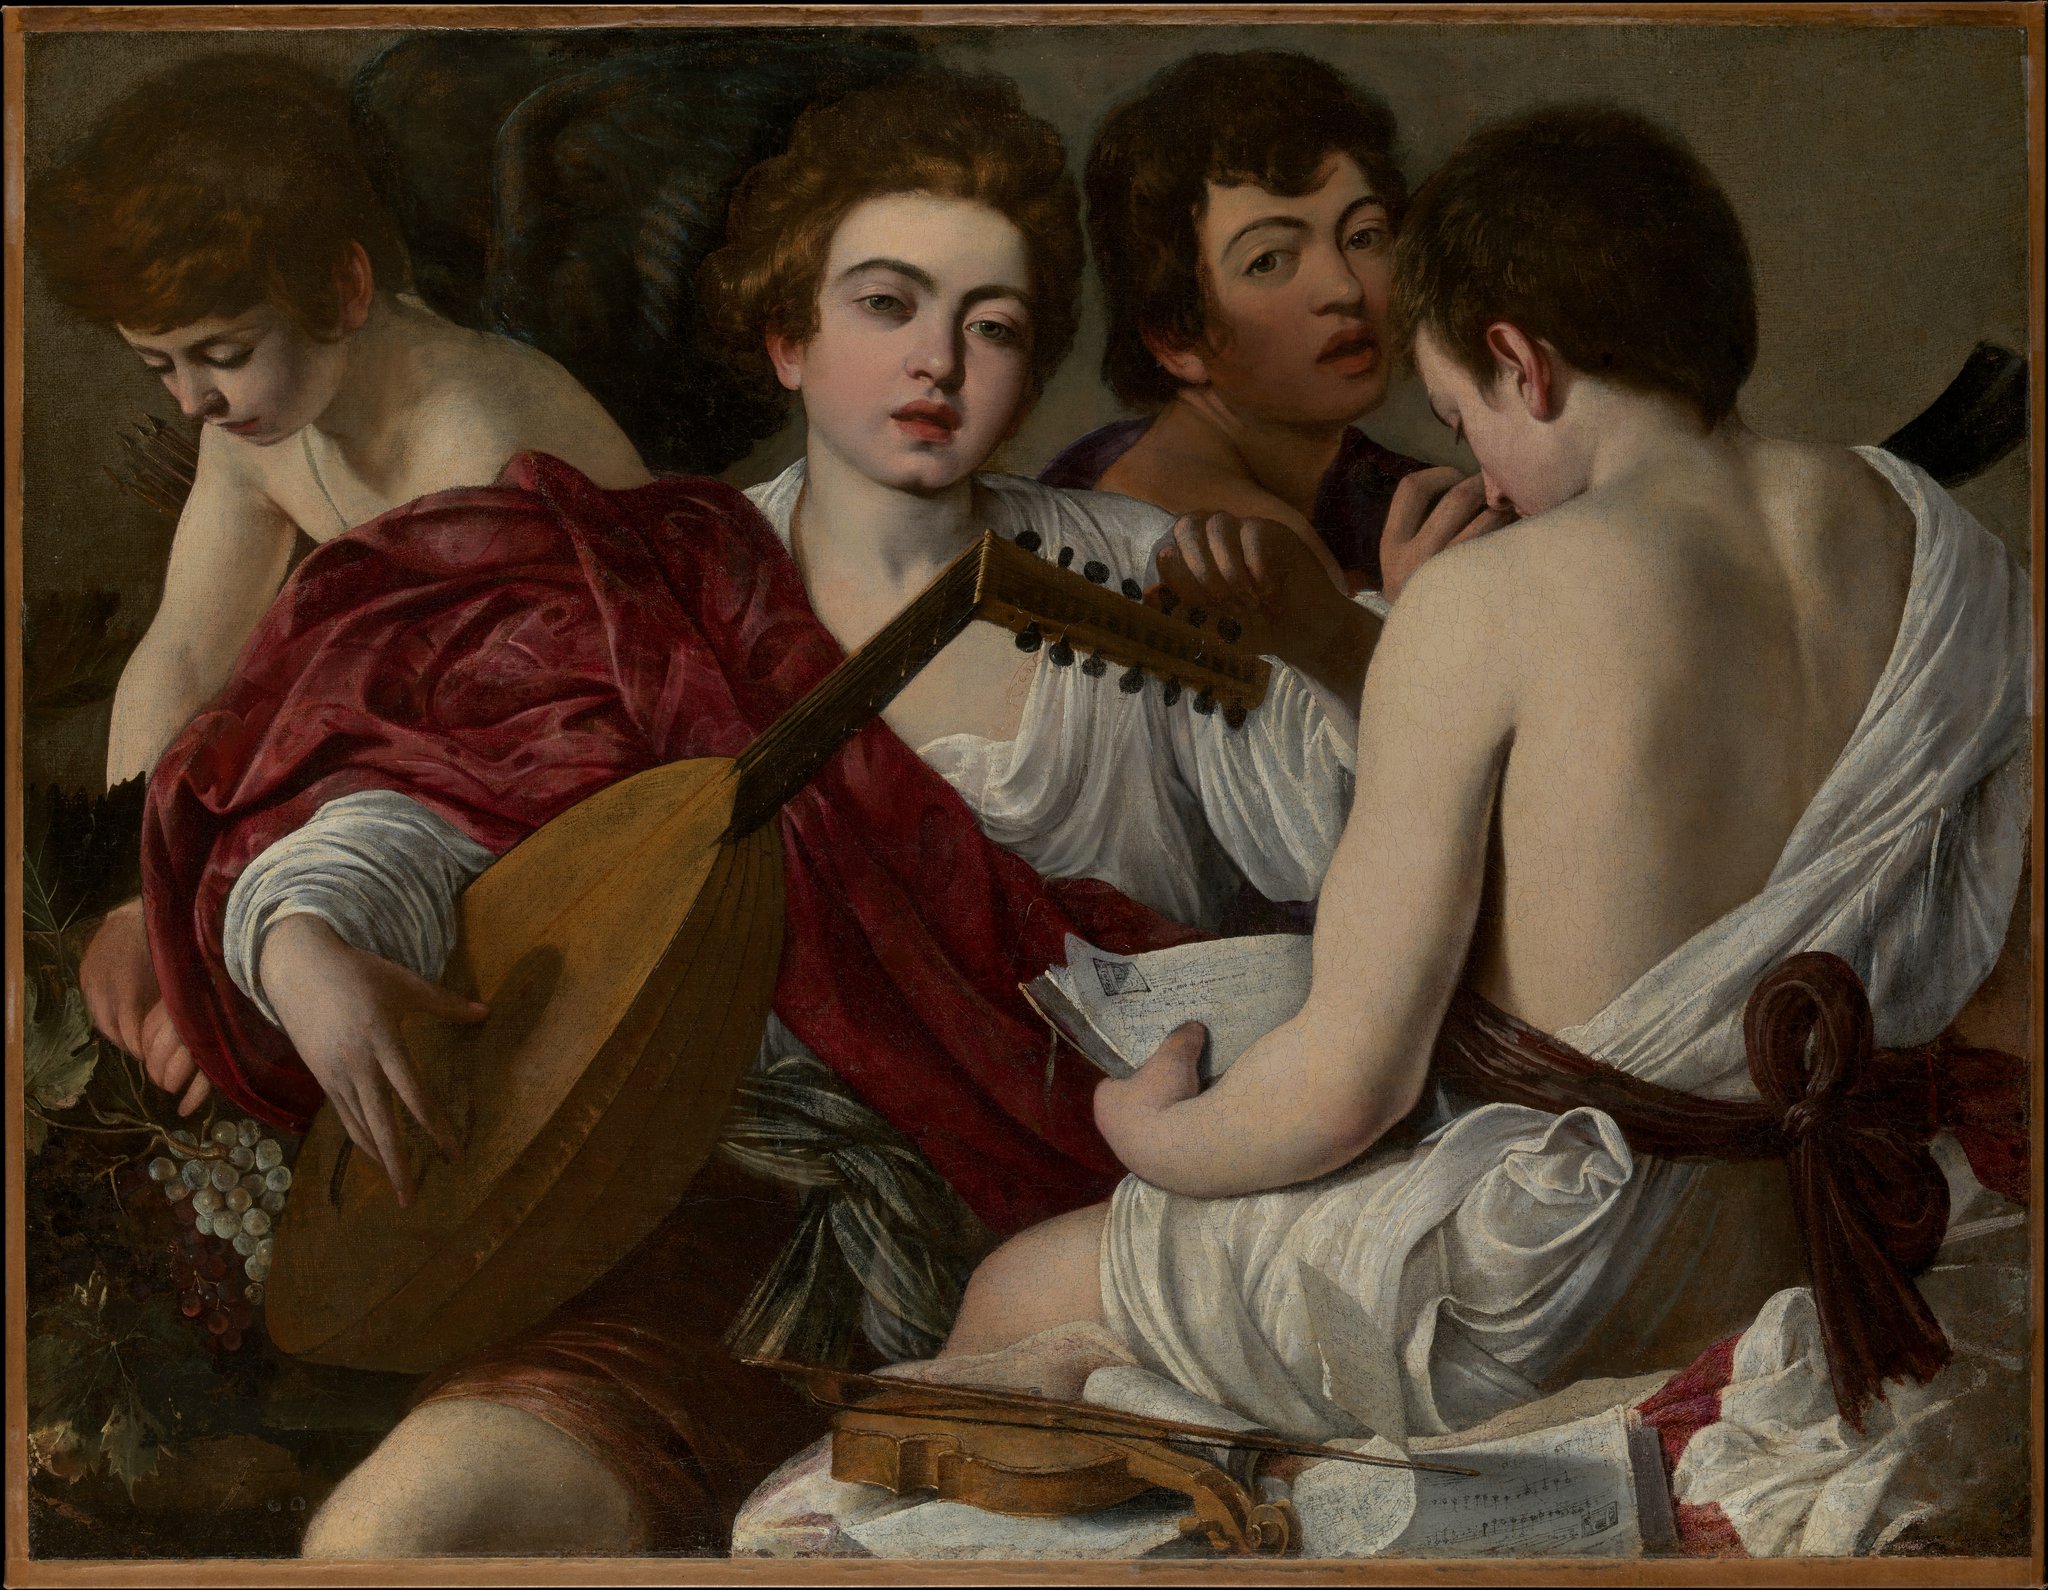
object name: painting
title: The Musicians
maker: caravaggio (michelangelo merisi)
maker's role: artist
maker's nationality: italian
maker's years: 1571-1610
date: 1597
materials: canvas, oil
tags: grapes,men,music,lutes,violins,cupid,musicians